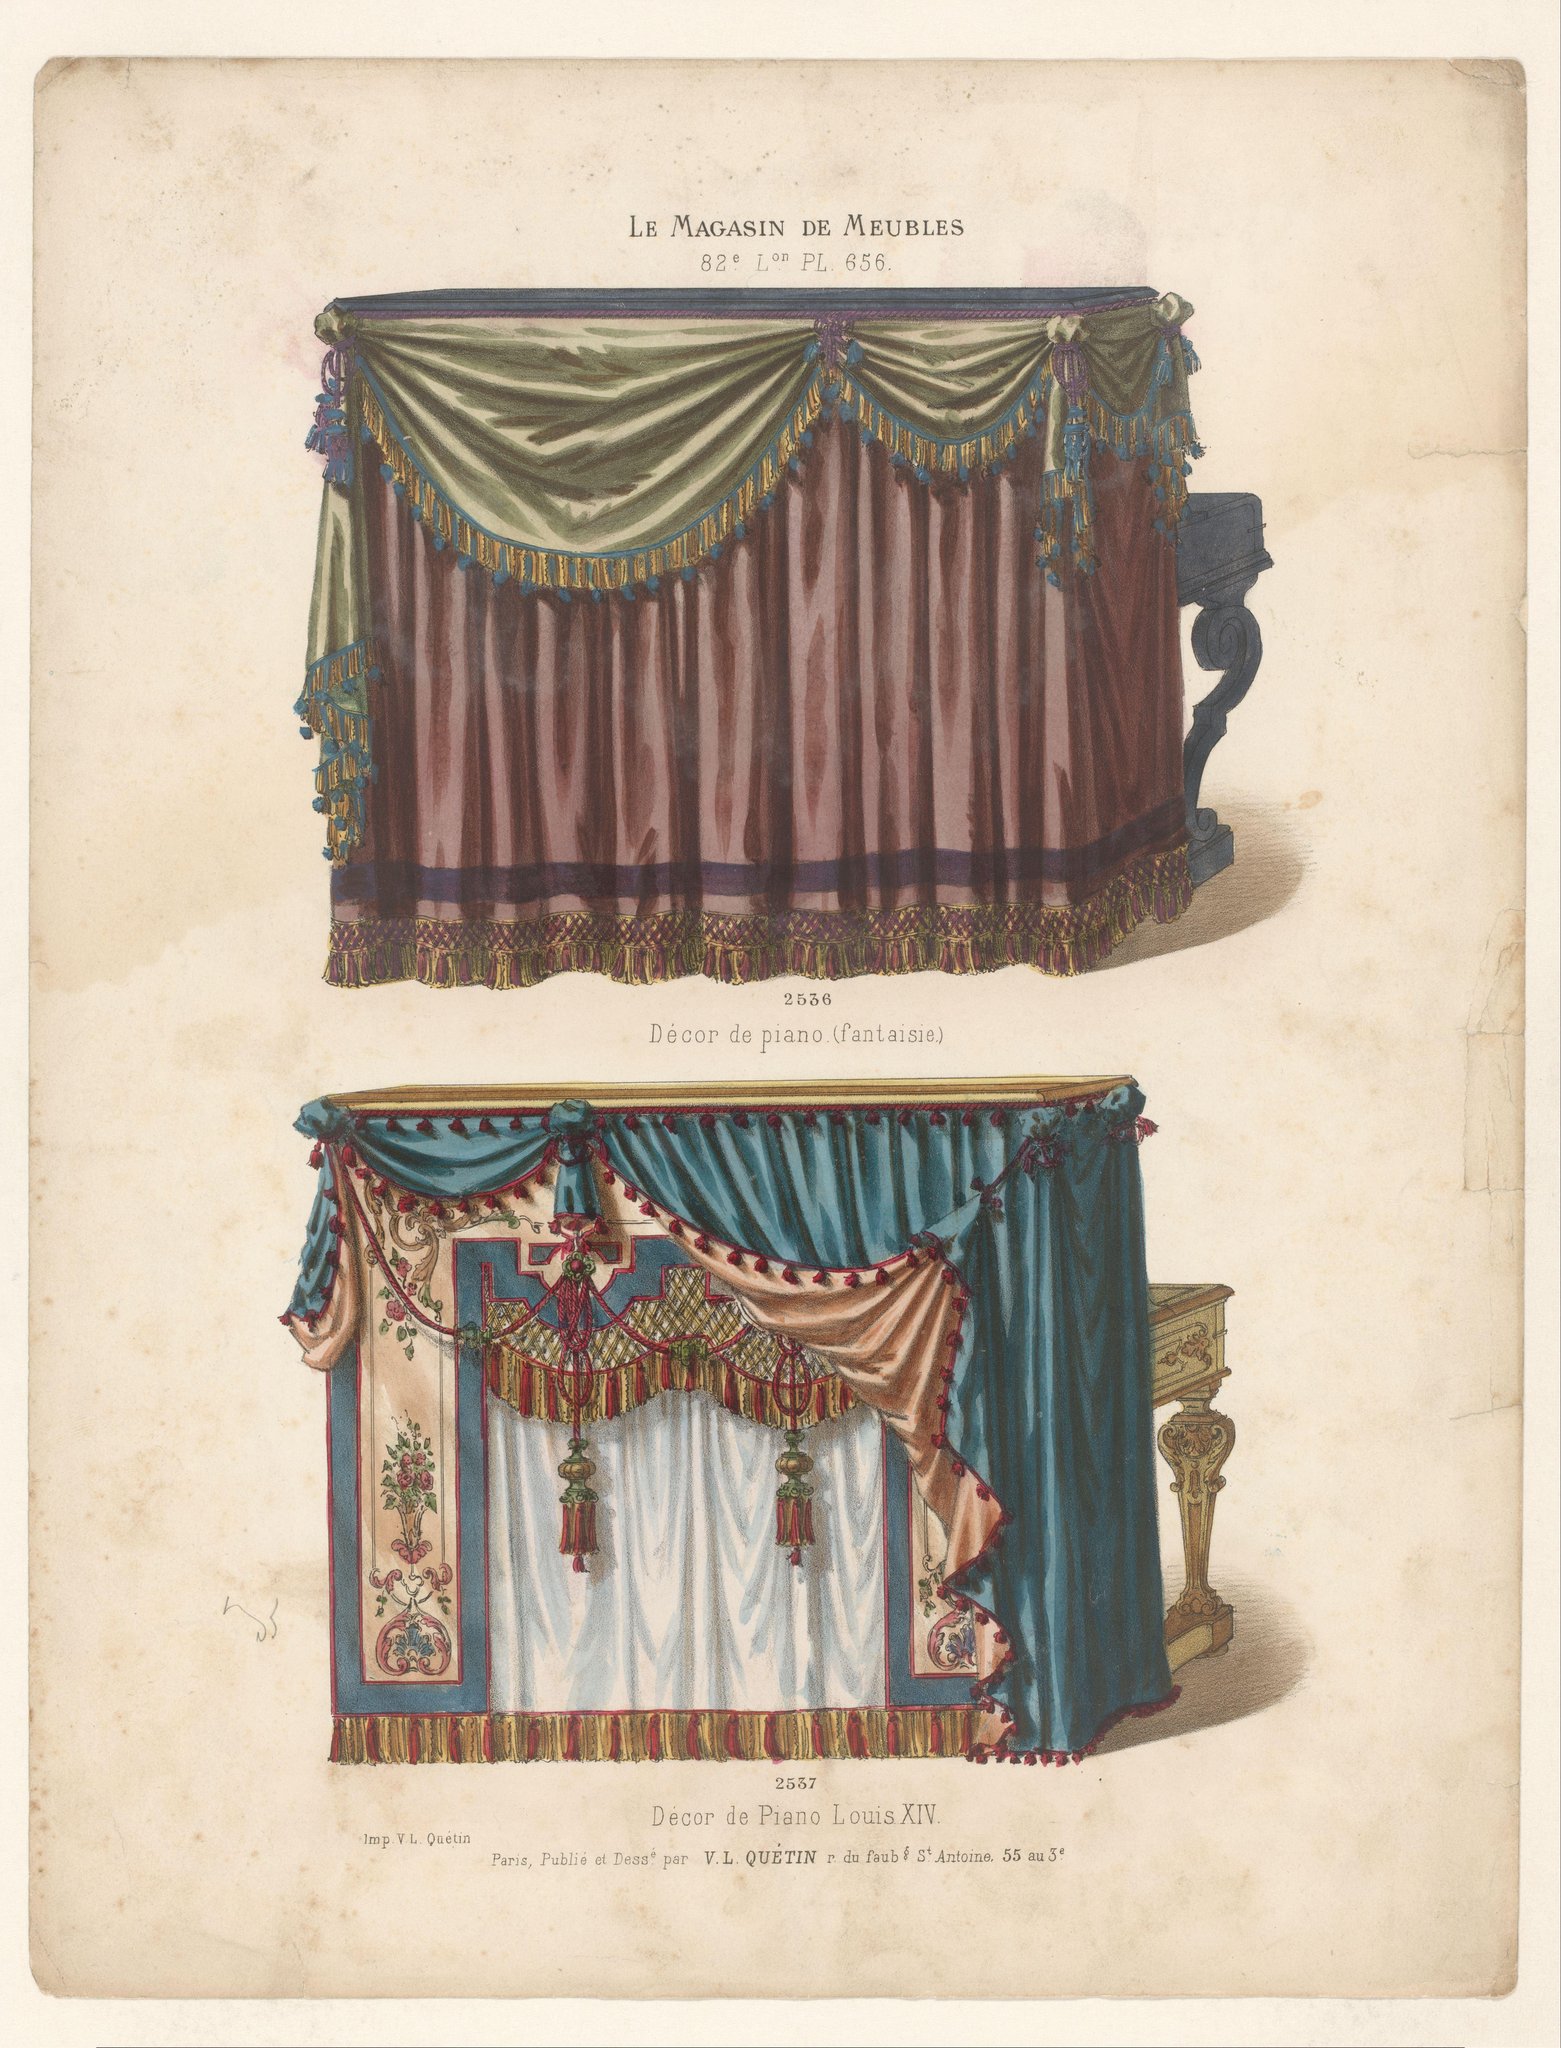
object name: print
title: Décor de Piano (fantaisie) / Décor de Piano Louis XIV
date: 1878-1904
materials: paper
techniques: hand coloring, lithograph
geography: paris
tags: hangings and drapery, pianoforte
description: Nummers 2536 en 2537. Twee piano's met draperieën, de eerste in fantasiestijl en de tweede in de Lodewijk XIV-stijl. Prent uit 82e Livraison.